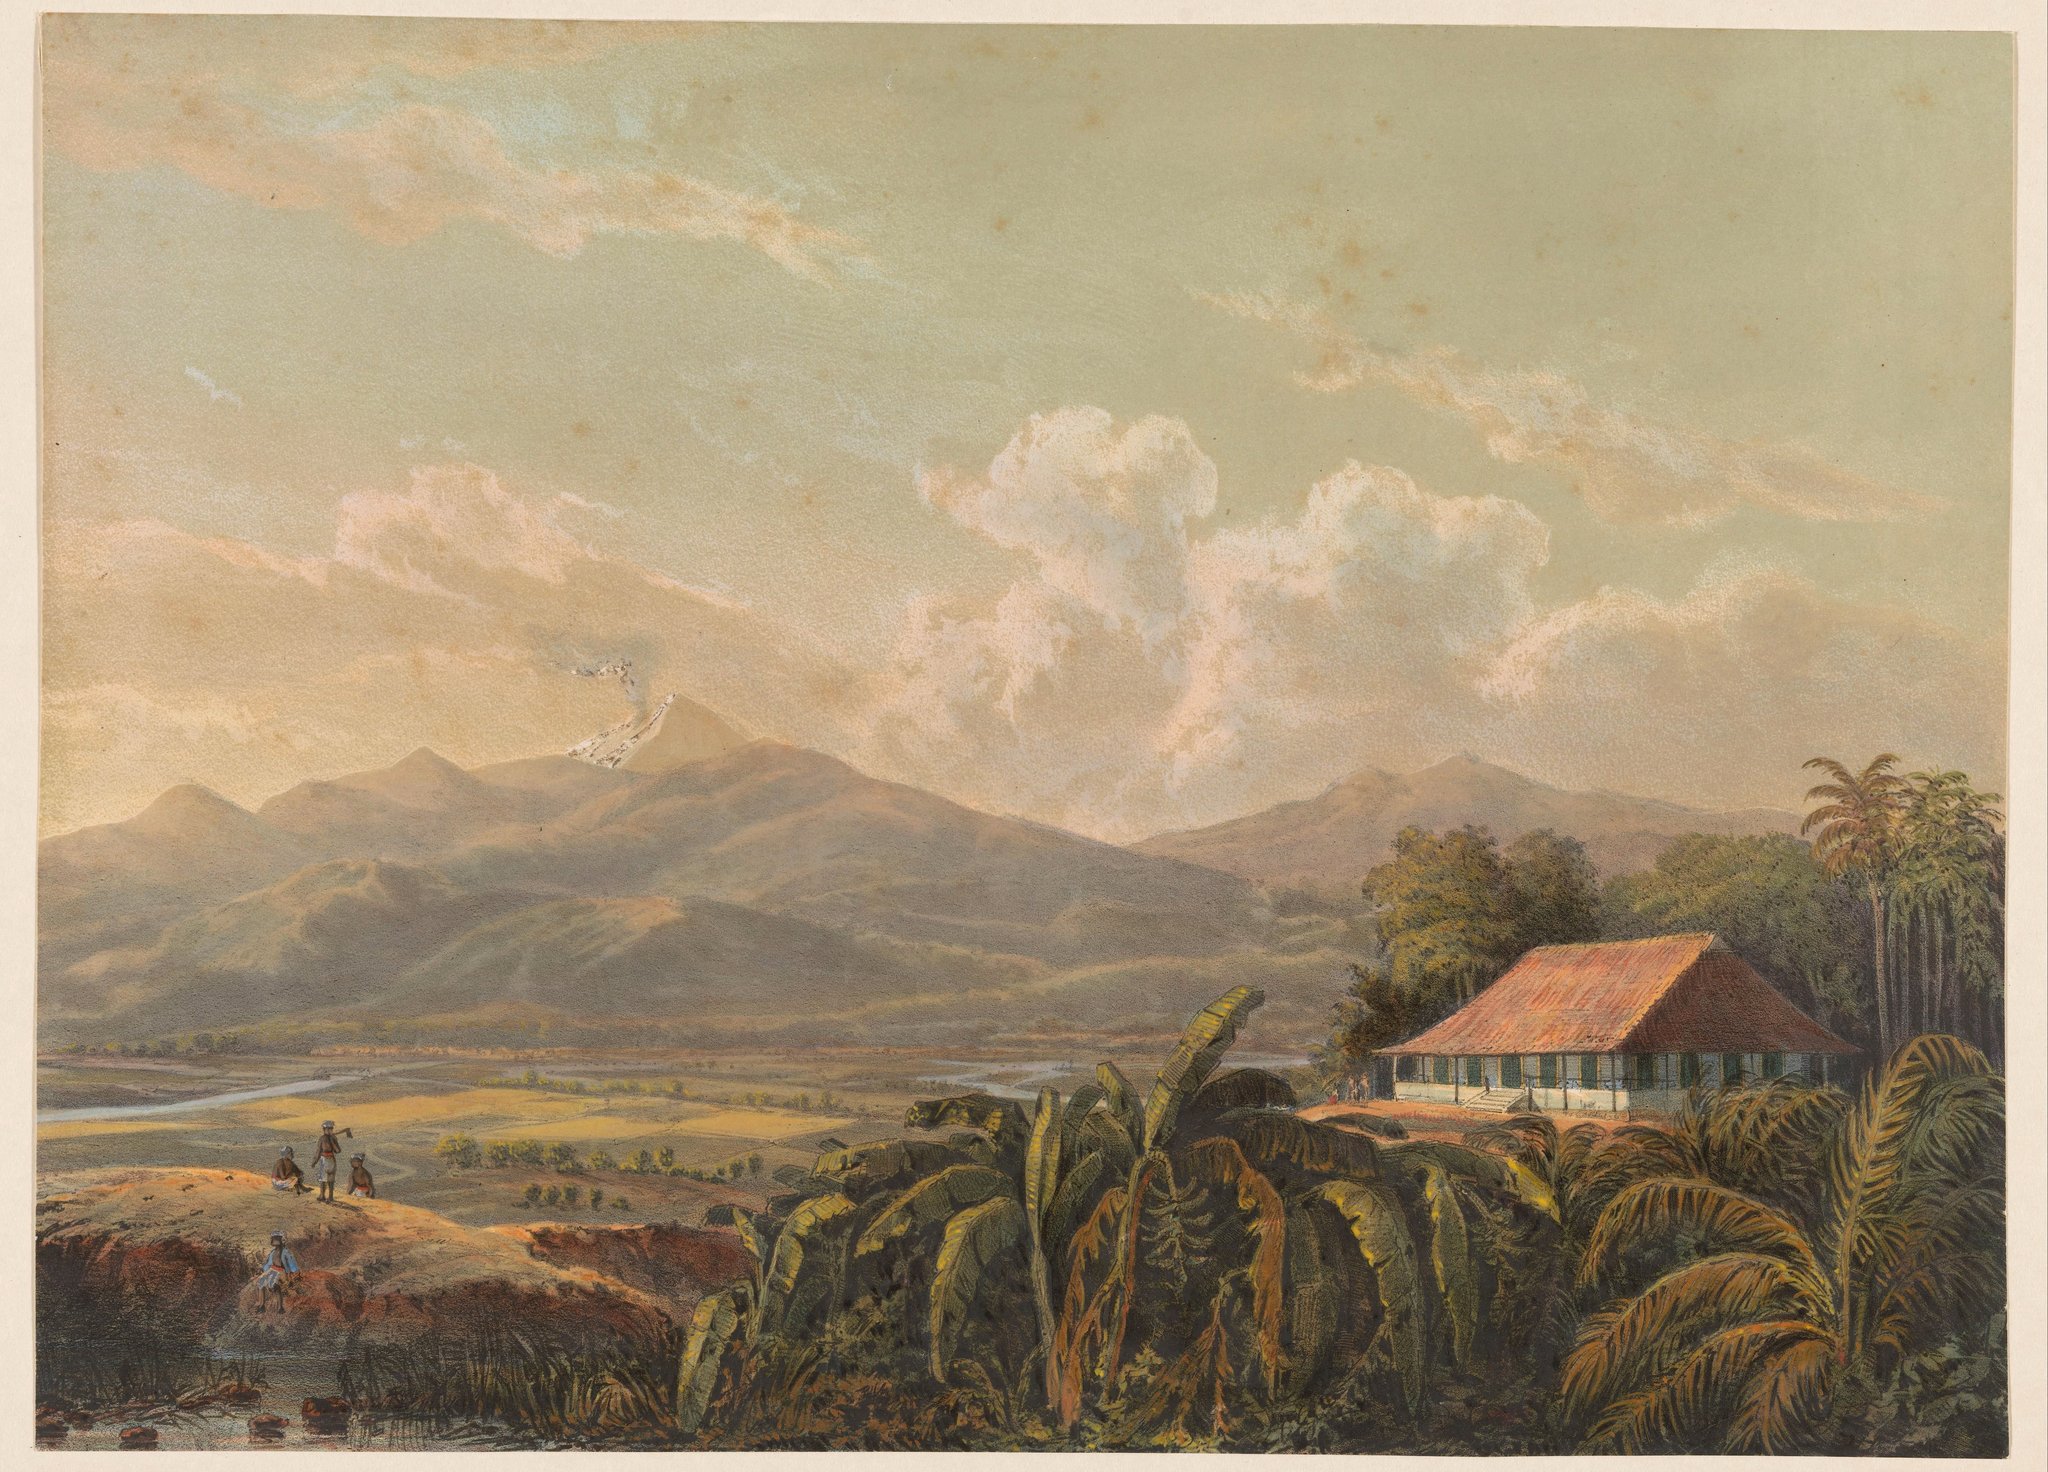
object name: print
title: Gezicht op landgoed en residentie Tjiptrap op Java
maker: johan conrad greive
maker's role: draughtsman, painter, print maker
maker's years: 1837-1891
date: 1869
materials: paper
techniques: lithograph, hand coloring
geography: dutch east indies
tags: landscapes in tropical and sub-tropical regions, volcano, java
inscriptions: collector's mark: Lugt 2228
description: Rechts het huis. Aan de horizon een rokende vulkaan. De prent maakt deel uit van een omslag met een tekstblad en 24 losse prenten.